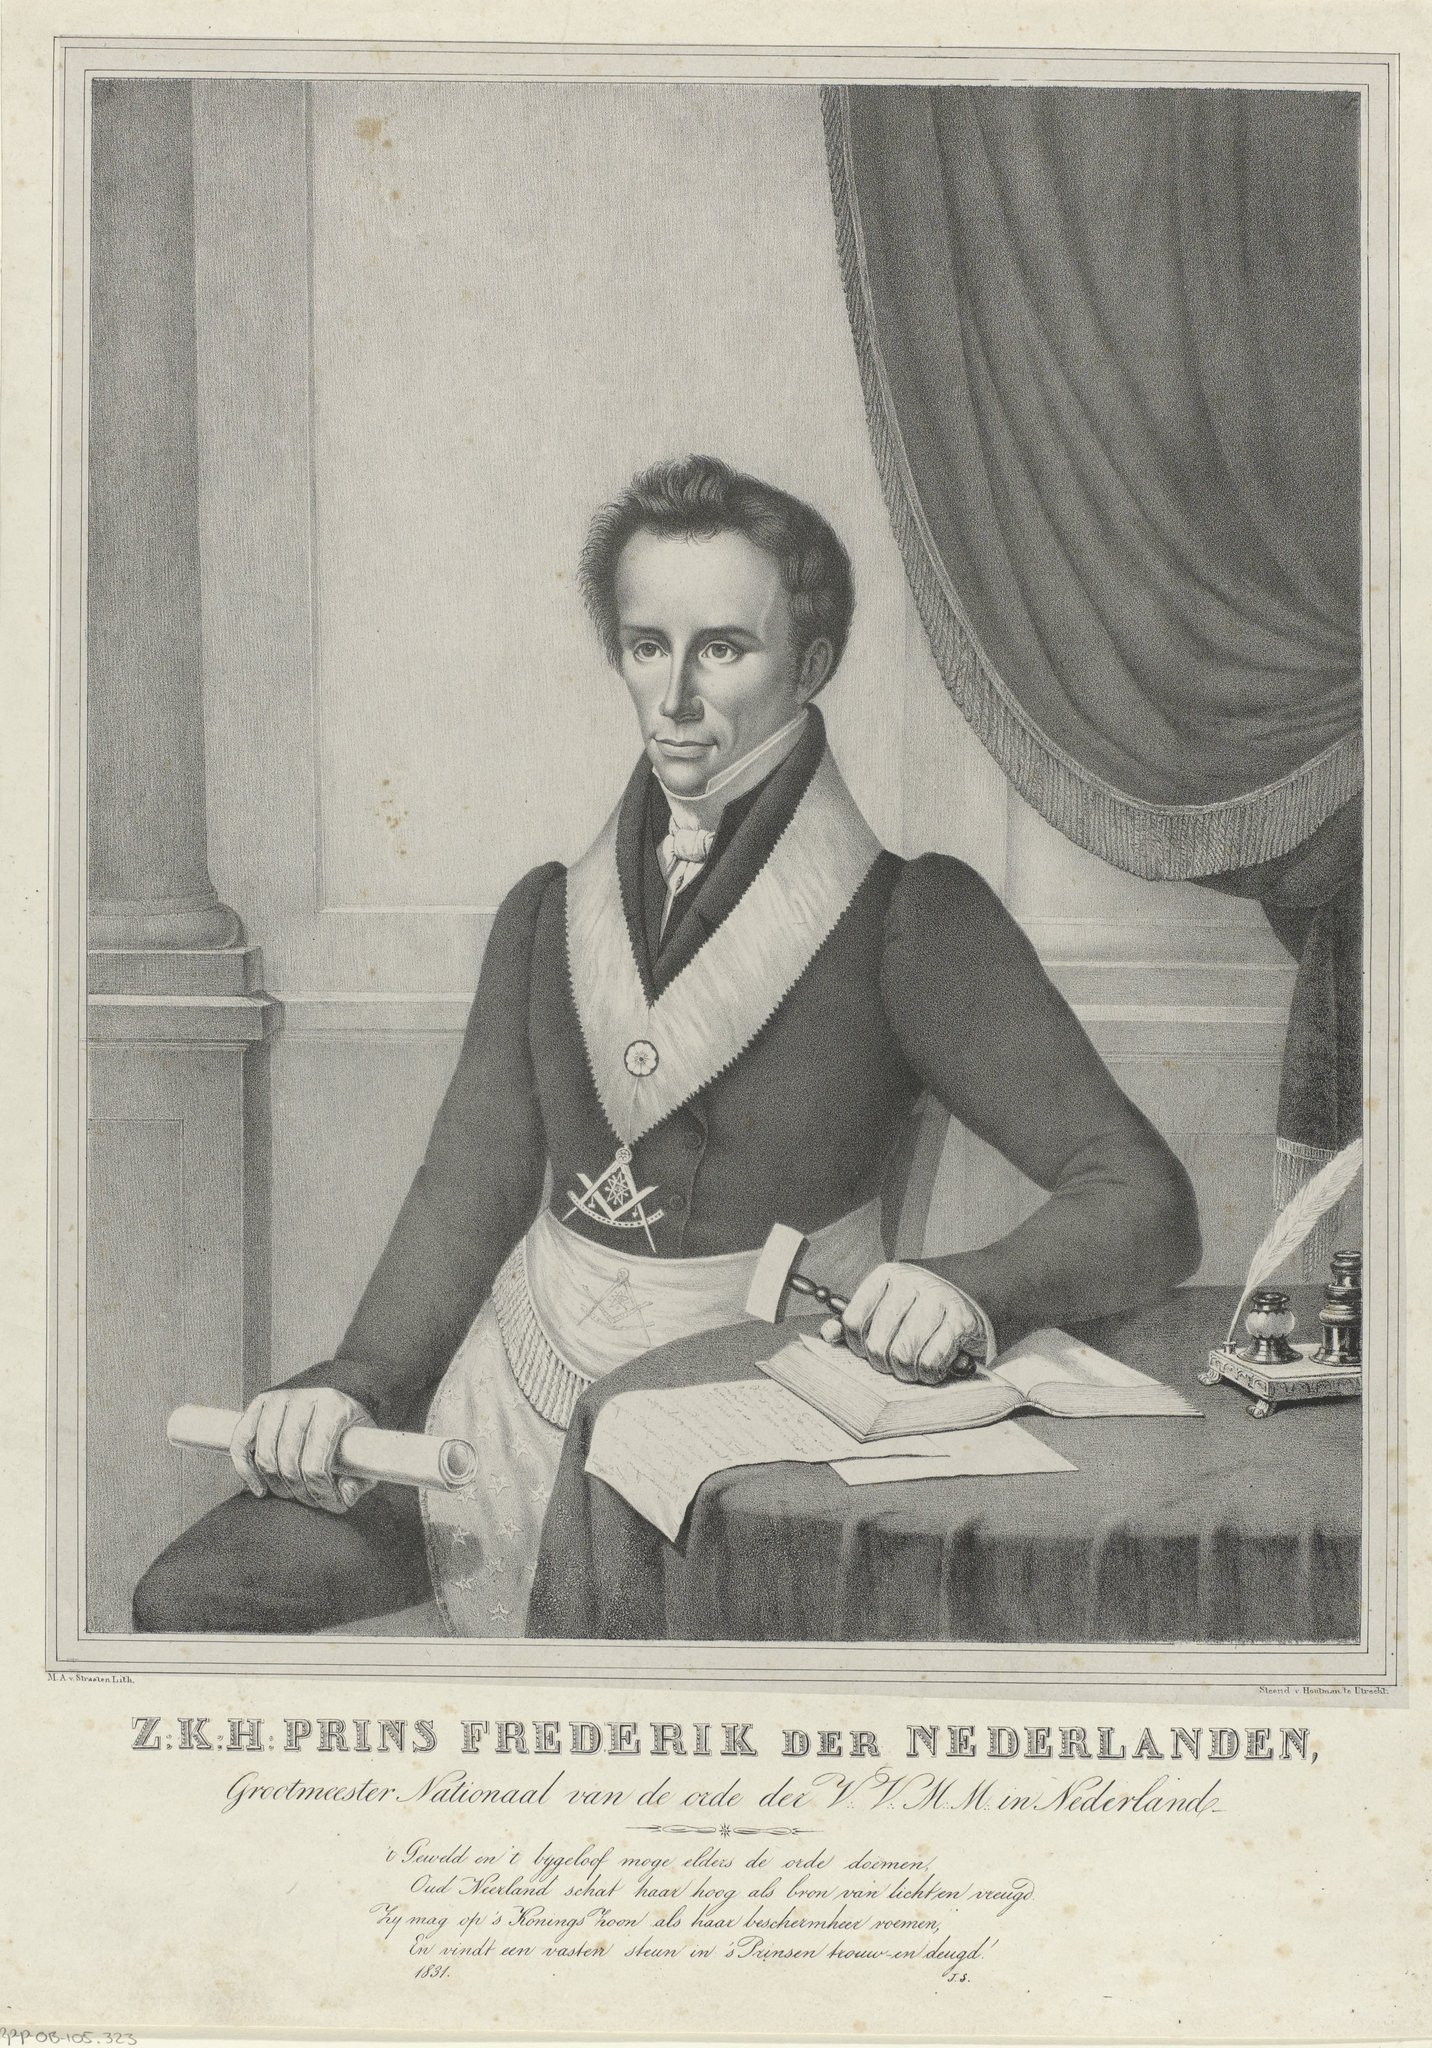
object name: print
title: Portret van Frederik, prins der Nederlanden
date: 1831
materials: paper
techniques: lithograph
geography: utrecht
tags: frederik (prins der nederlanden)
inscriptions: date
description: Portret van Frederik als grootmeester der Vrijmetselaren. Hij zit achter een tafel. In zijn rechterhand een rol. In zijn linkerhand een hamer. Daaronder ligt een boek met papieren. Daarnaast staat een inktpot met een pen. In de ondermarge zijn naam, zijn titels en vier regels Nederlandse tekst.